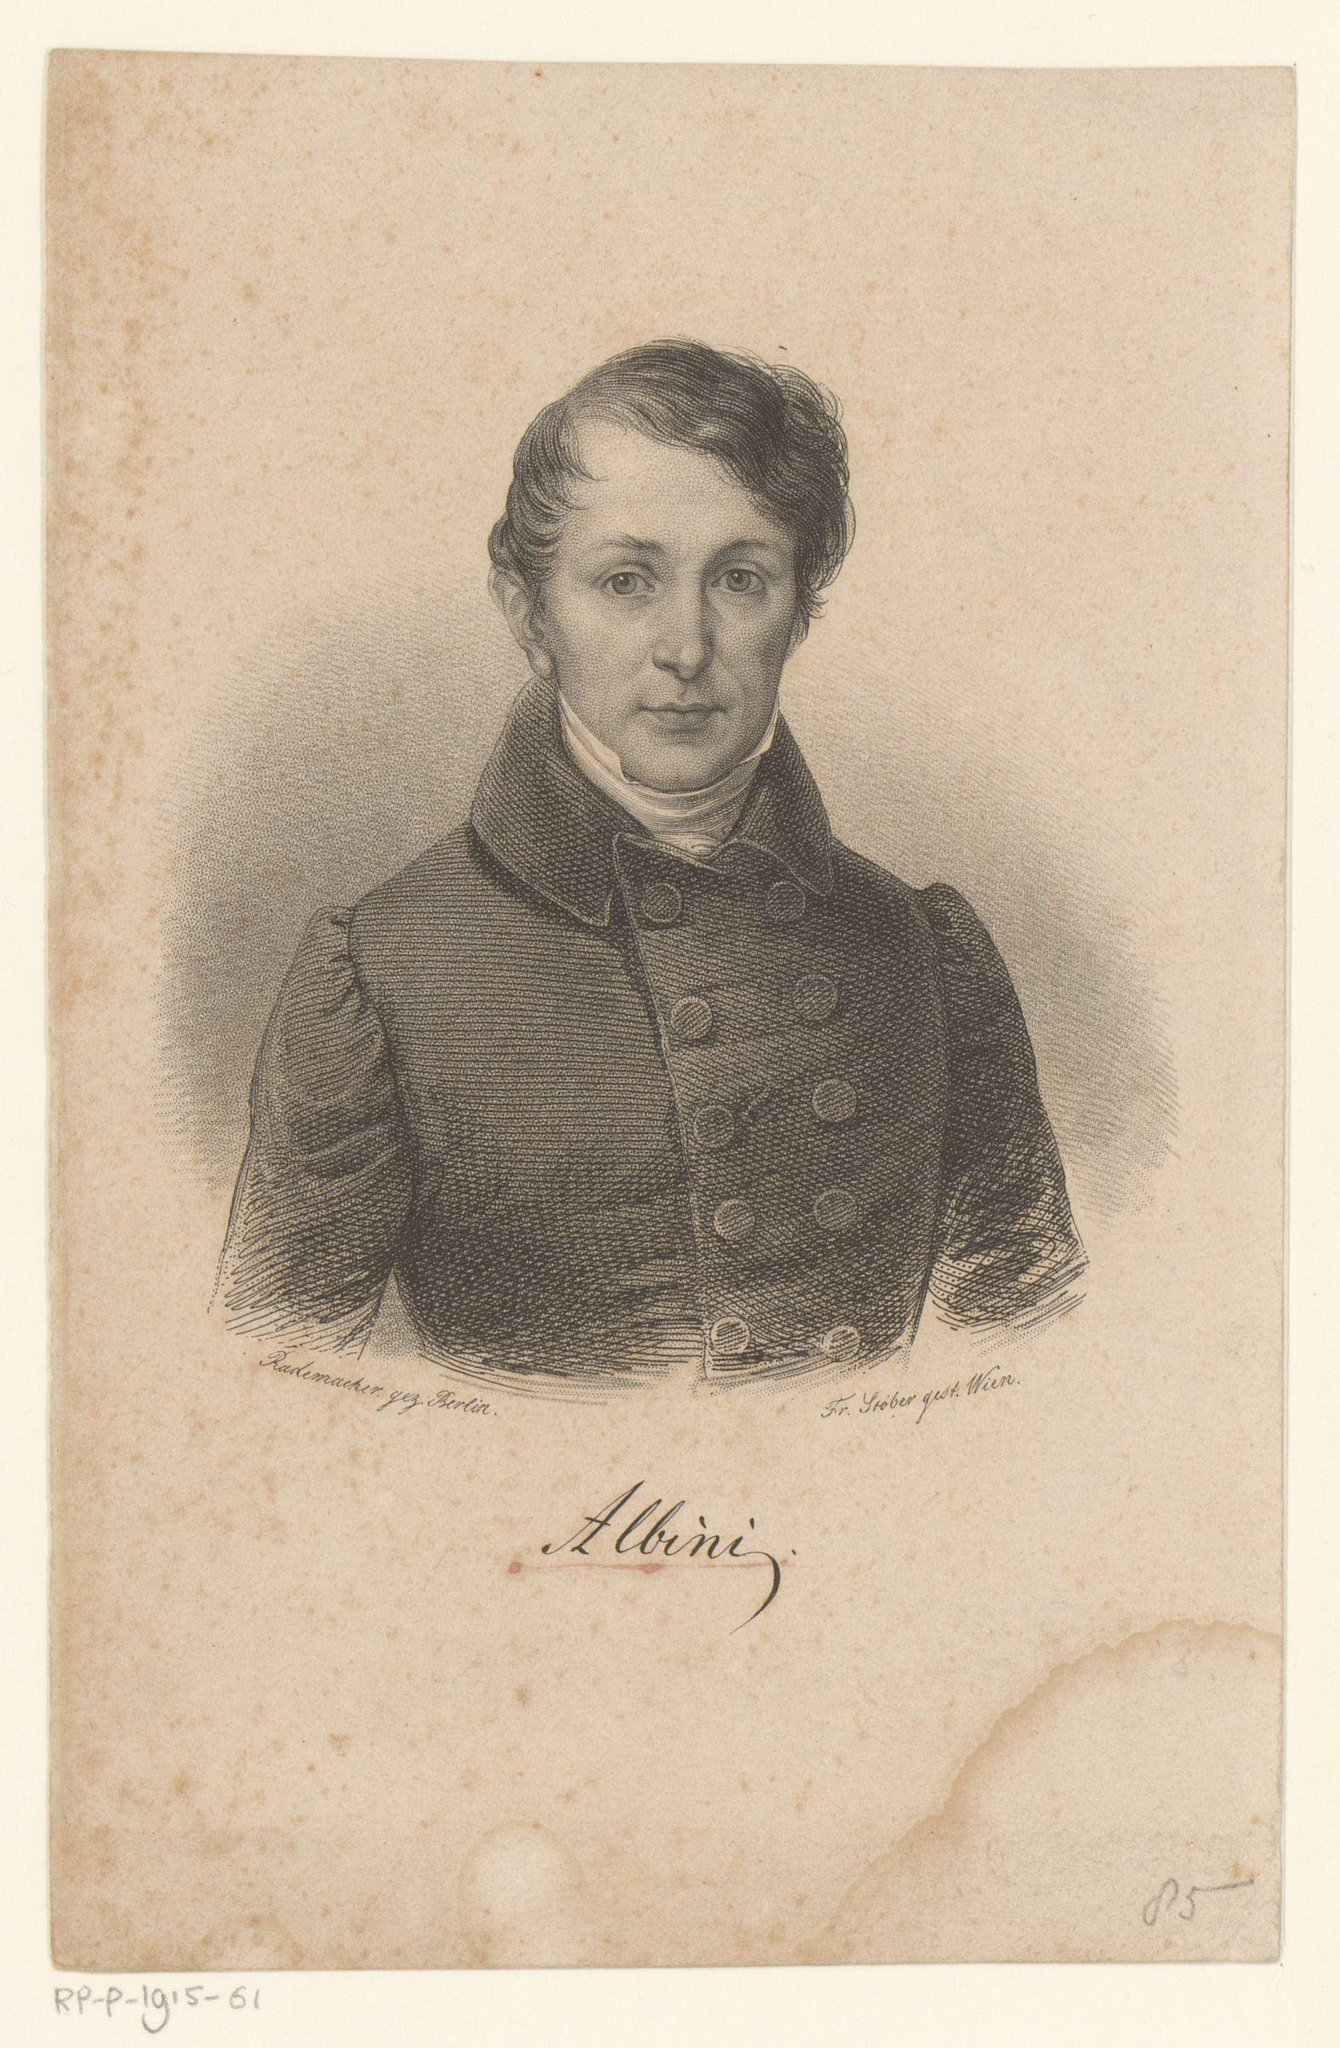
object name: print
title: Portret van Albin Johann Baptist von Meddlhammer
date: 1800-1858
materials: paper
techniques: etching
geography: berlin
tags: historical persons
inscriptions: collector's mark: Lugt 2228